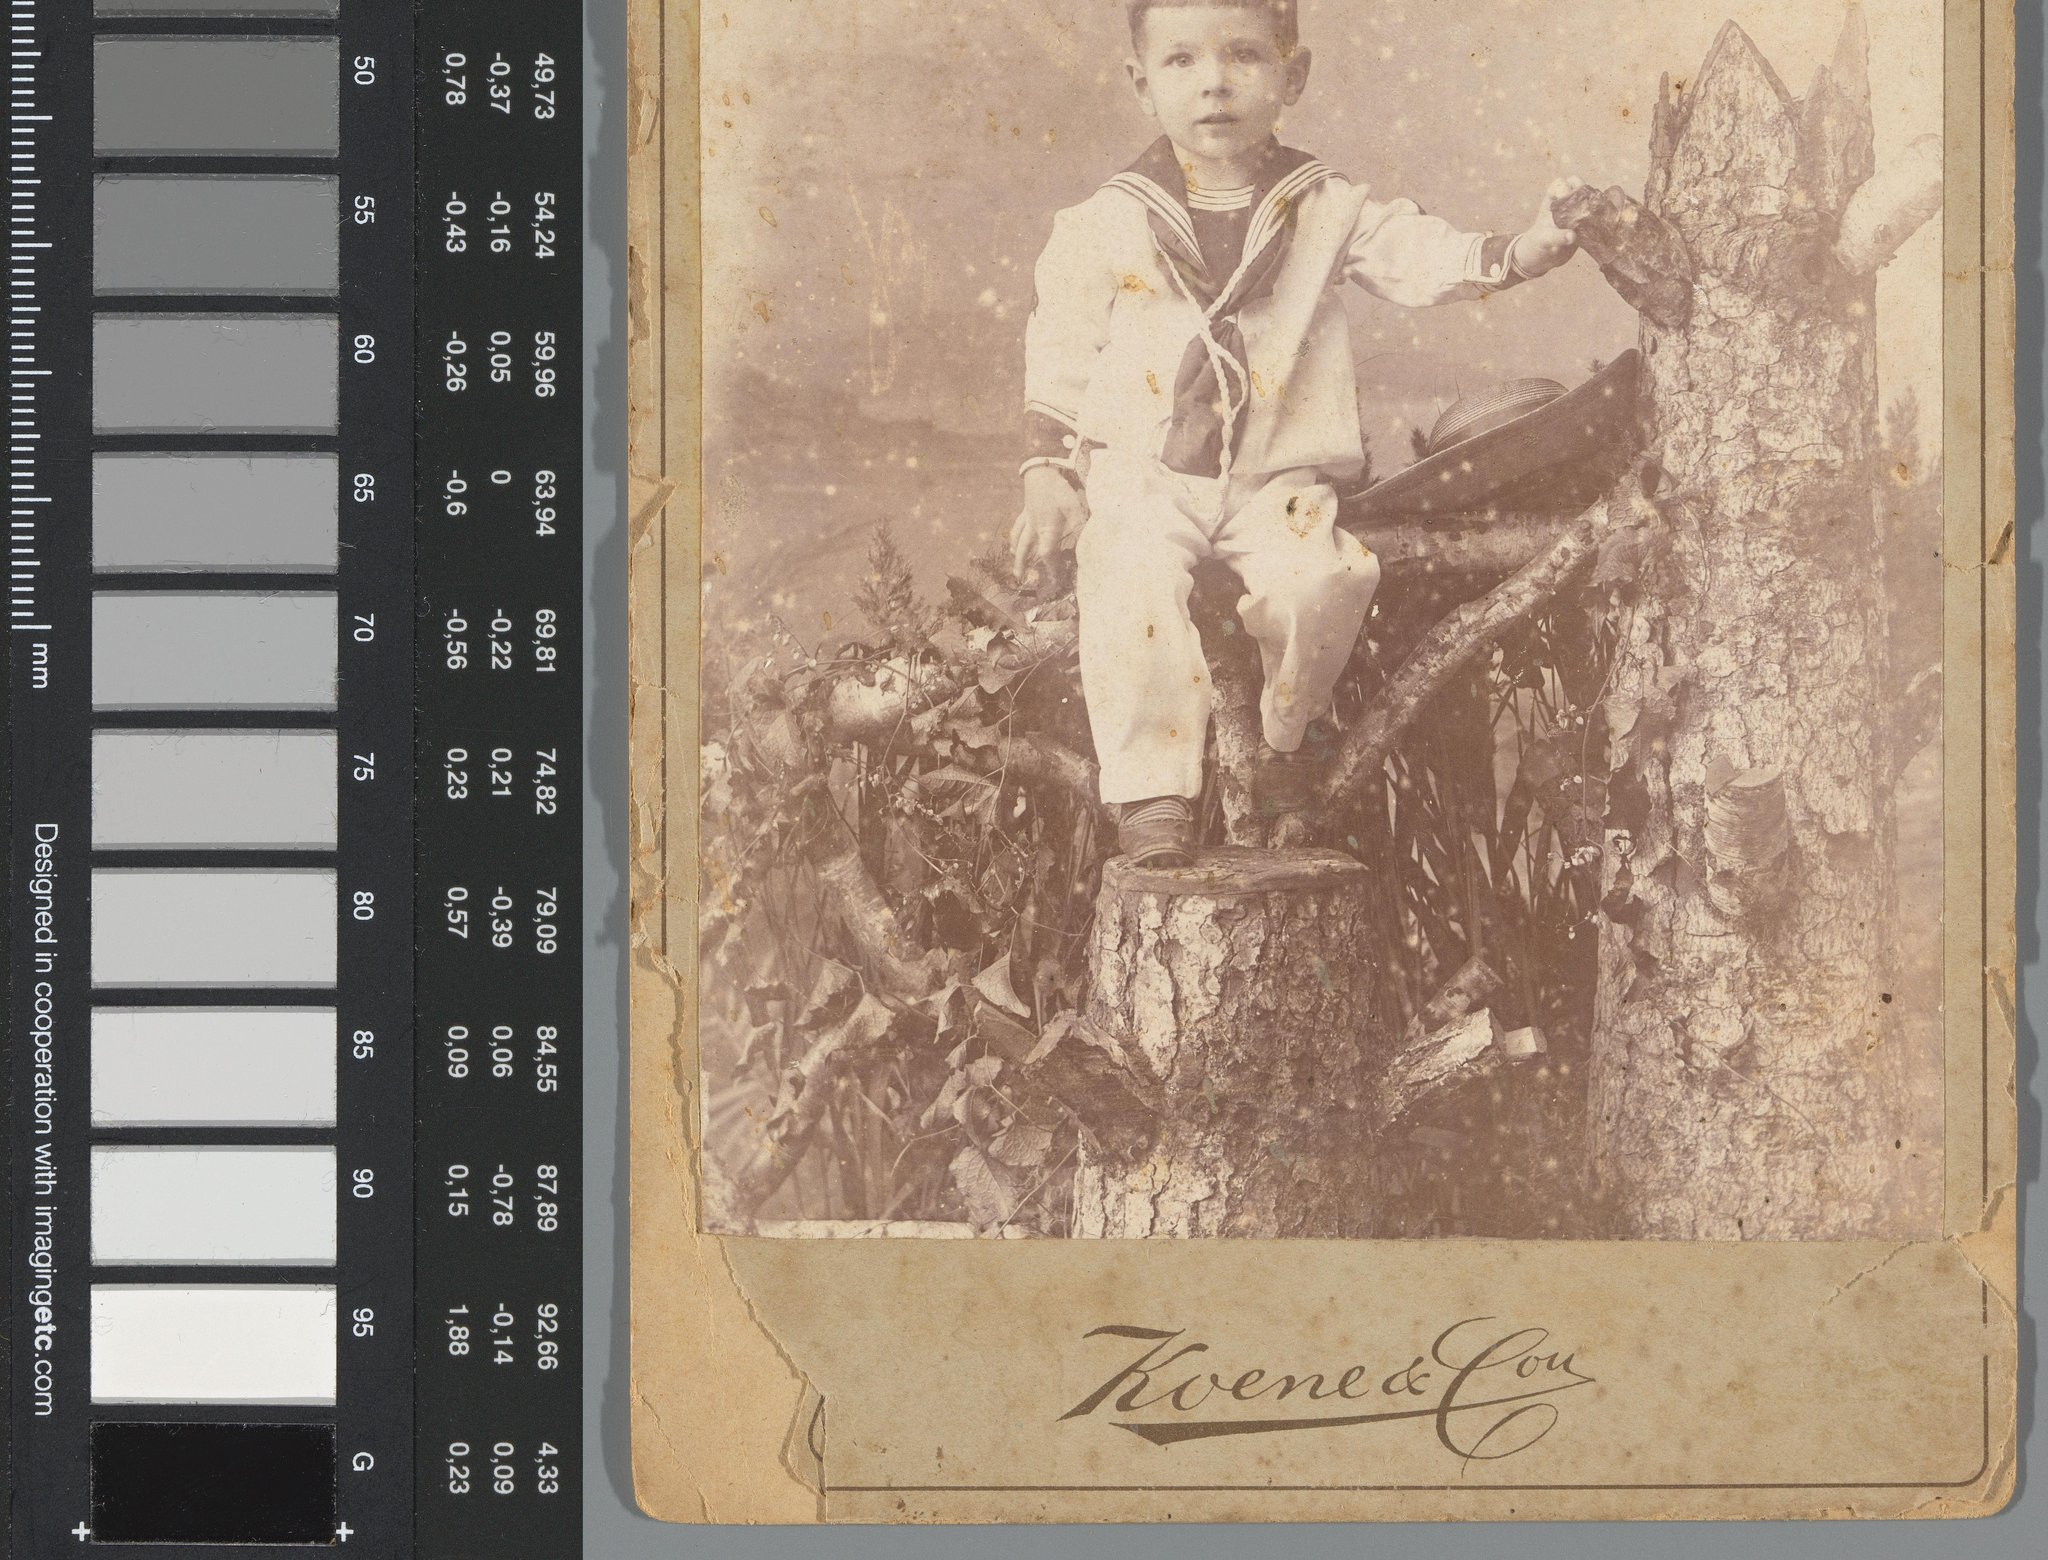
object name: cabinet photograph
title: Studioportret van zoon van Emilie van den Berg en Piet Onnen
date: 1890-1920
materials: cardboard, photographic support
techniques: albumen print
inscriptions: name: ‘Koene & Co’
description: Jongen in matrozenpak zittend op takken.